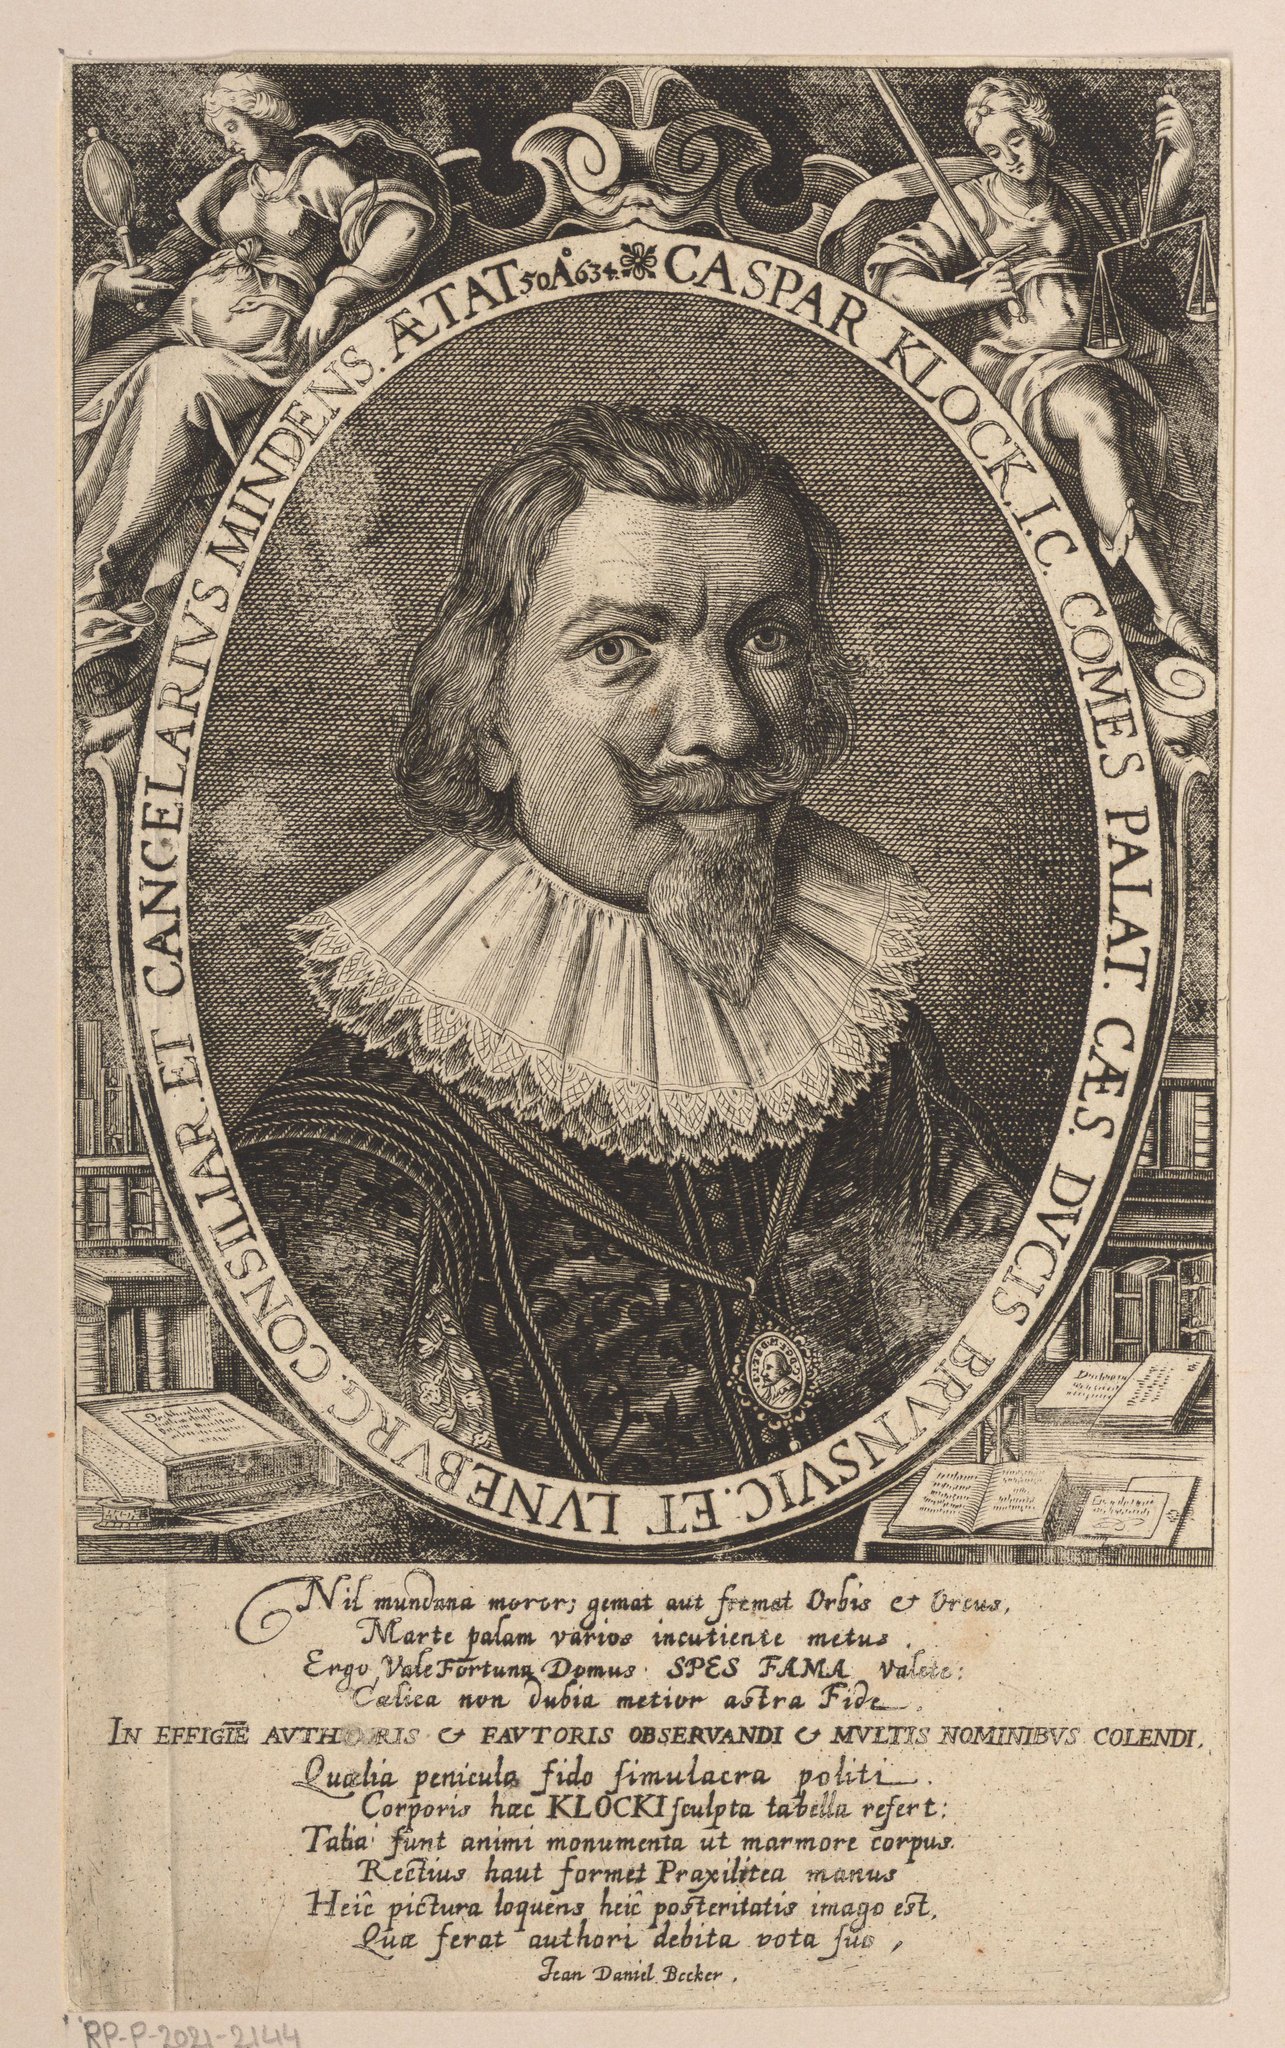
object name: print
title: Portret van Caspar Klock op 50-jarige leeftijd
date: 1634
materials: paper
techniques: lithograph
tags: bookshelves, justice, 'justitia'; 'giustitia divina' (ripa) ~ one of the four cardinal virtues, prudence, 'prudentia'; 'prudenza' (ripa) ~ one of the four cardinal virtues, historical persons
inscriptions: date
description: Boven het portret Voorzichtigheid en Rechtvaardigheid, onder het portret een elfregelig vers.